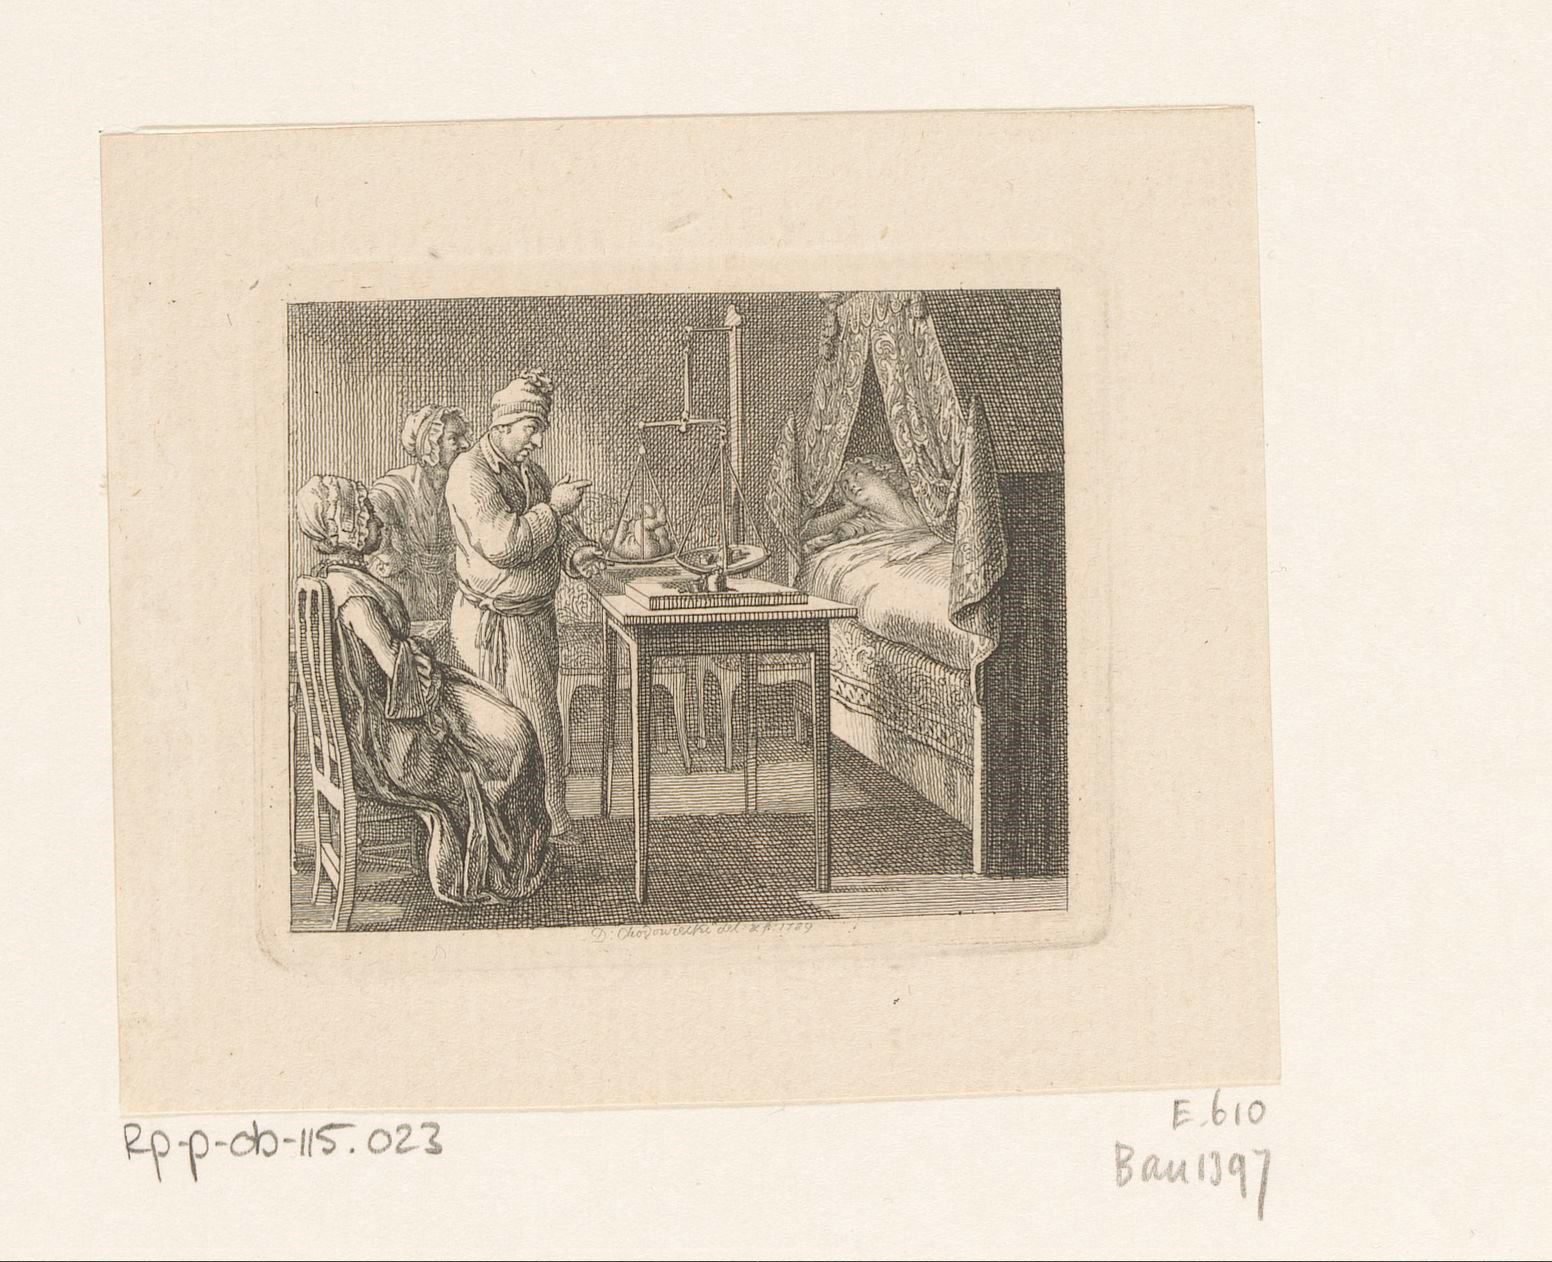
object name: print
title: Weging van de pasgeborene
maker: daniel nikolaus chodowiecki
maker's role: draughtsman, print maker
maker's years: 1726-1801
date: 1789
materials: paper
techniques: etching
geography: berlin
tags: literature, scales, the new-born child, lying-in room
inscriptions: collector's mark: Lugt 2228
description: Prent gebruikt voor: Hermes, Johann Timotheus. Zween litterarische Märtyrer und deren Frauen vom Verfasser von Sophiens Reise. 2 dln. Leipzig: Johann Friedrich Junius, 1789.